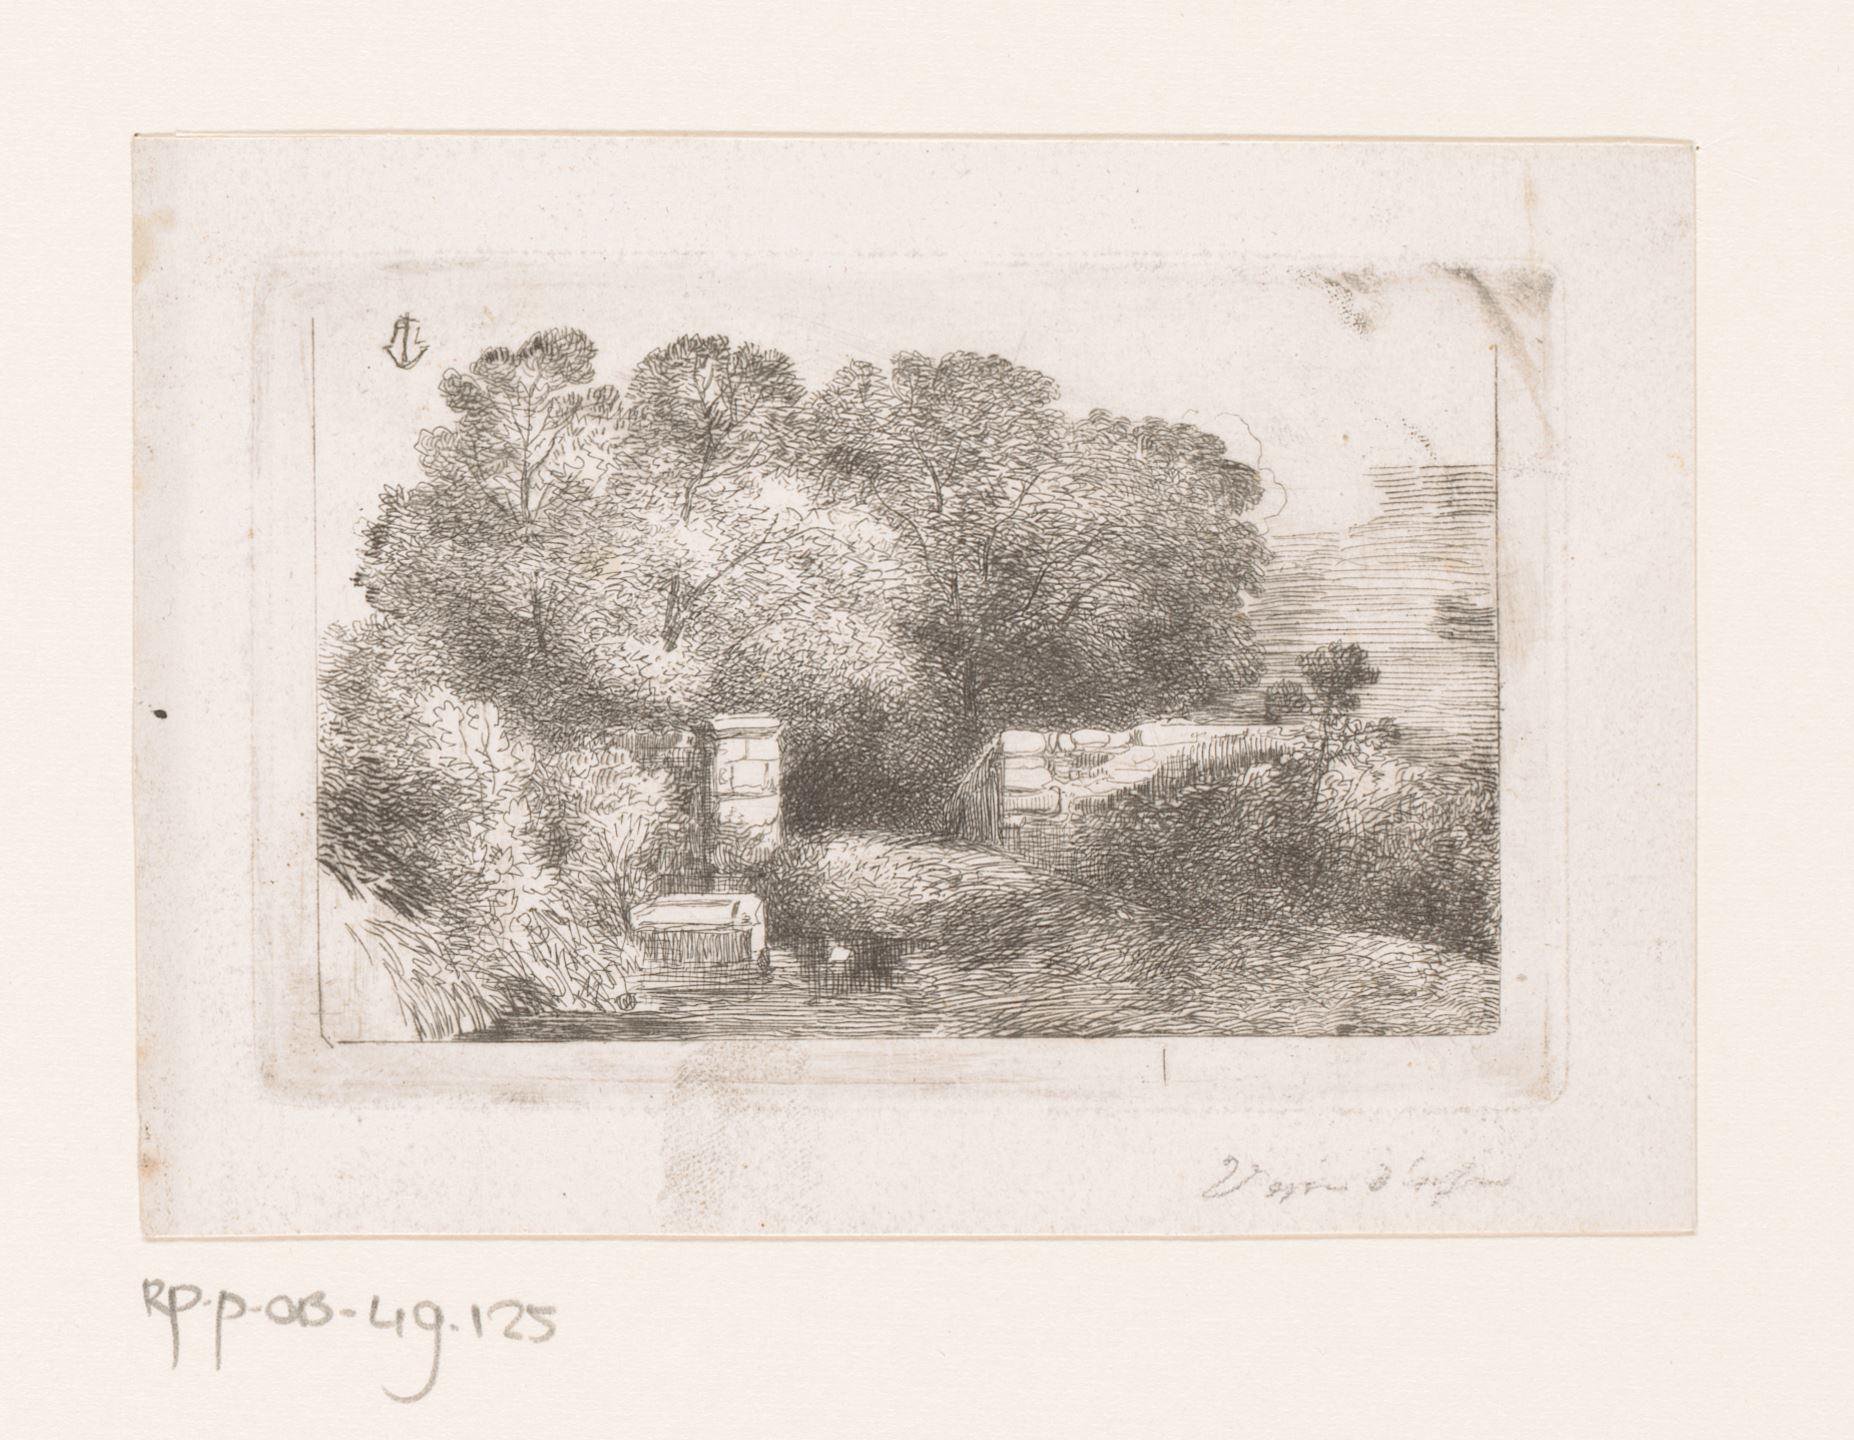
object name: print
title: Lage stenen muur met een pad door het midden naar een boompartij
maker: paulus lauters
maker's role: print maker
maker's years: 1806-1875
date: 1816-1875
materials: paper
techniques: etching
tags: forest path or lane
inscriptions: collector's mark: Lugt 2228, annotation: ‘2e épr. d'état’